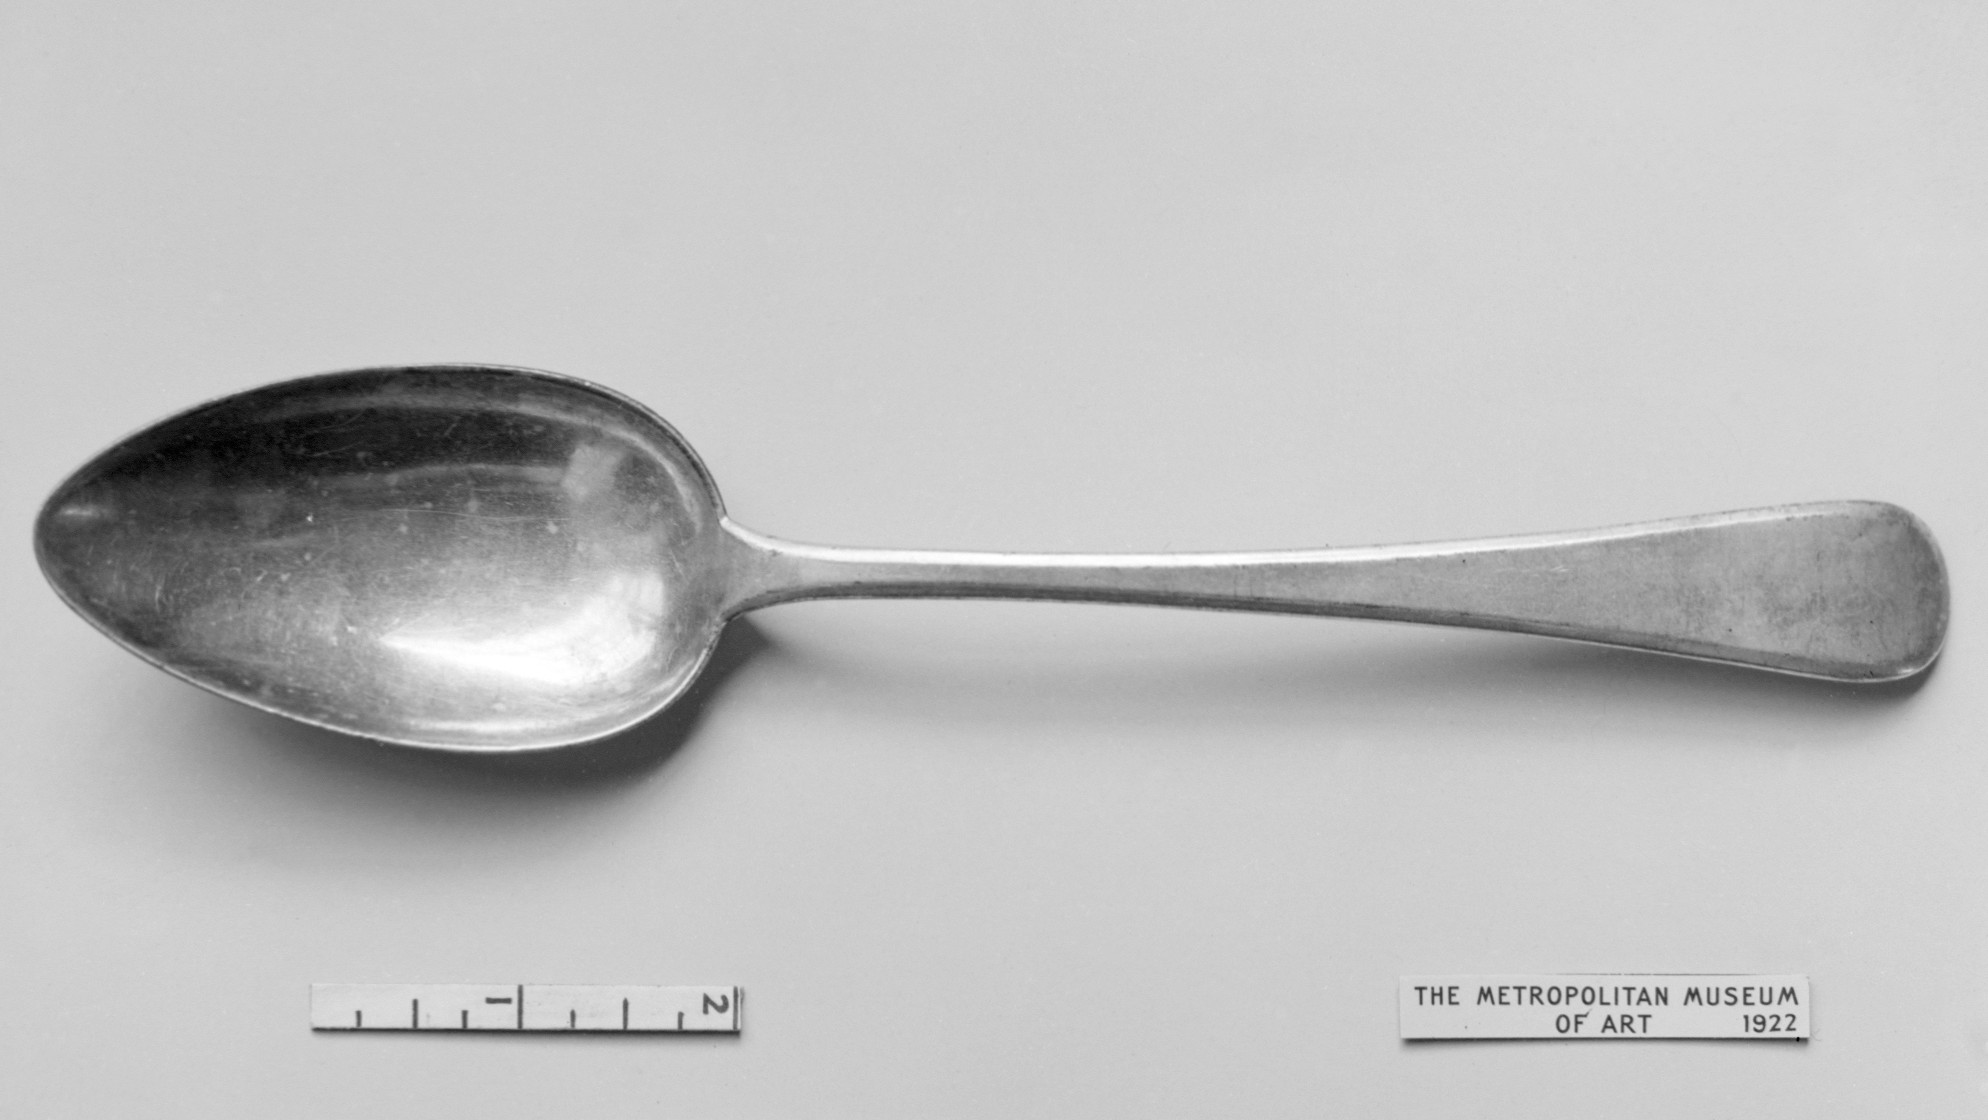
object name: tablespoon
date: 1765-1785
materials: metal